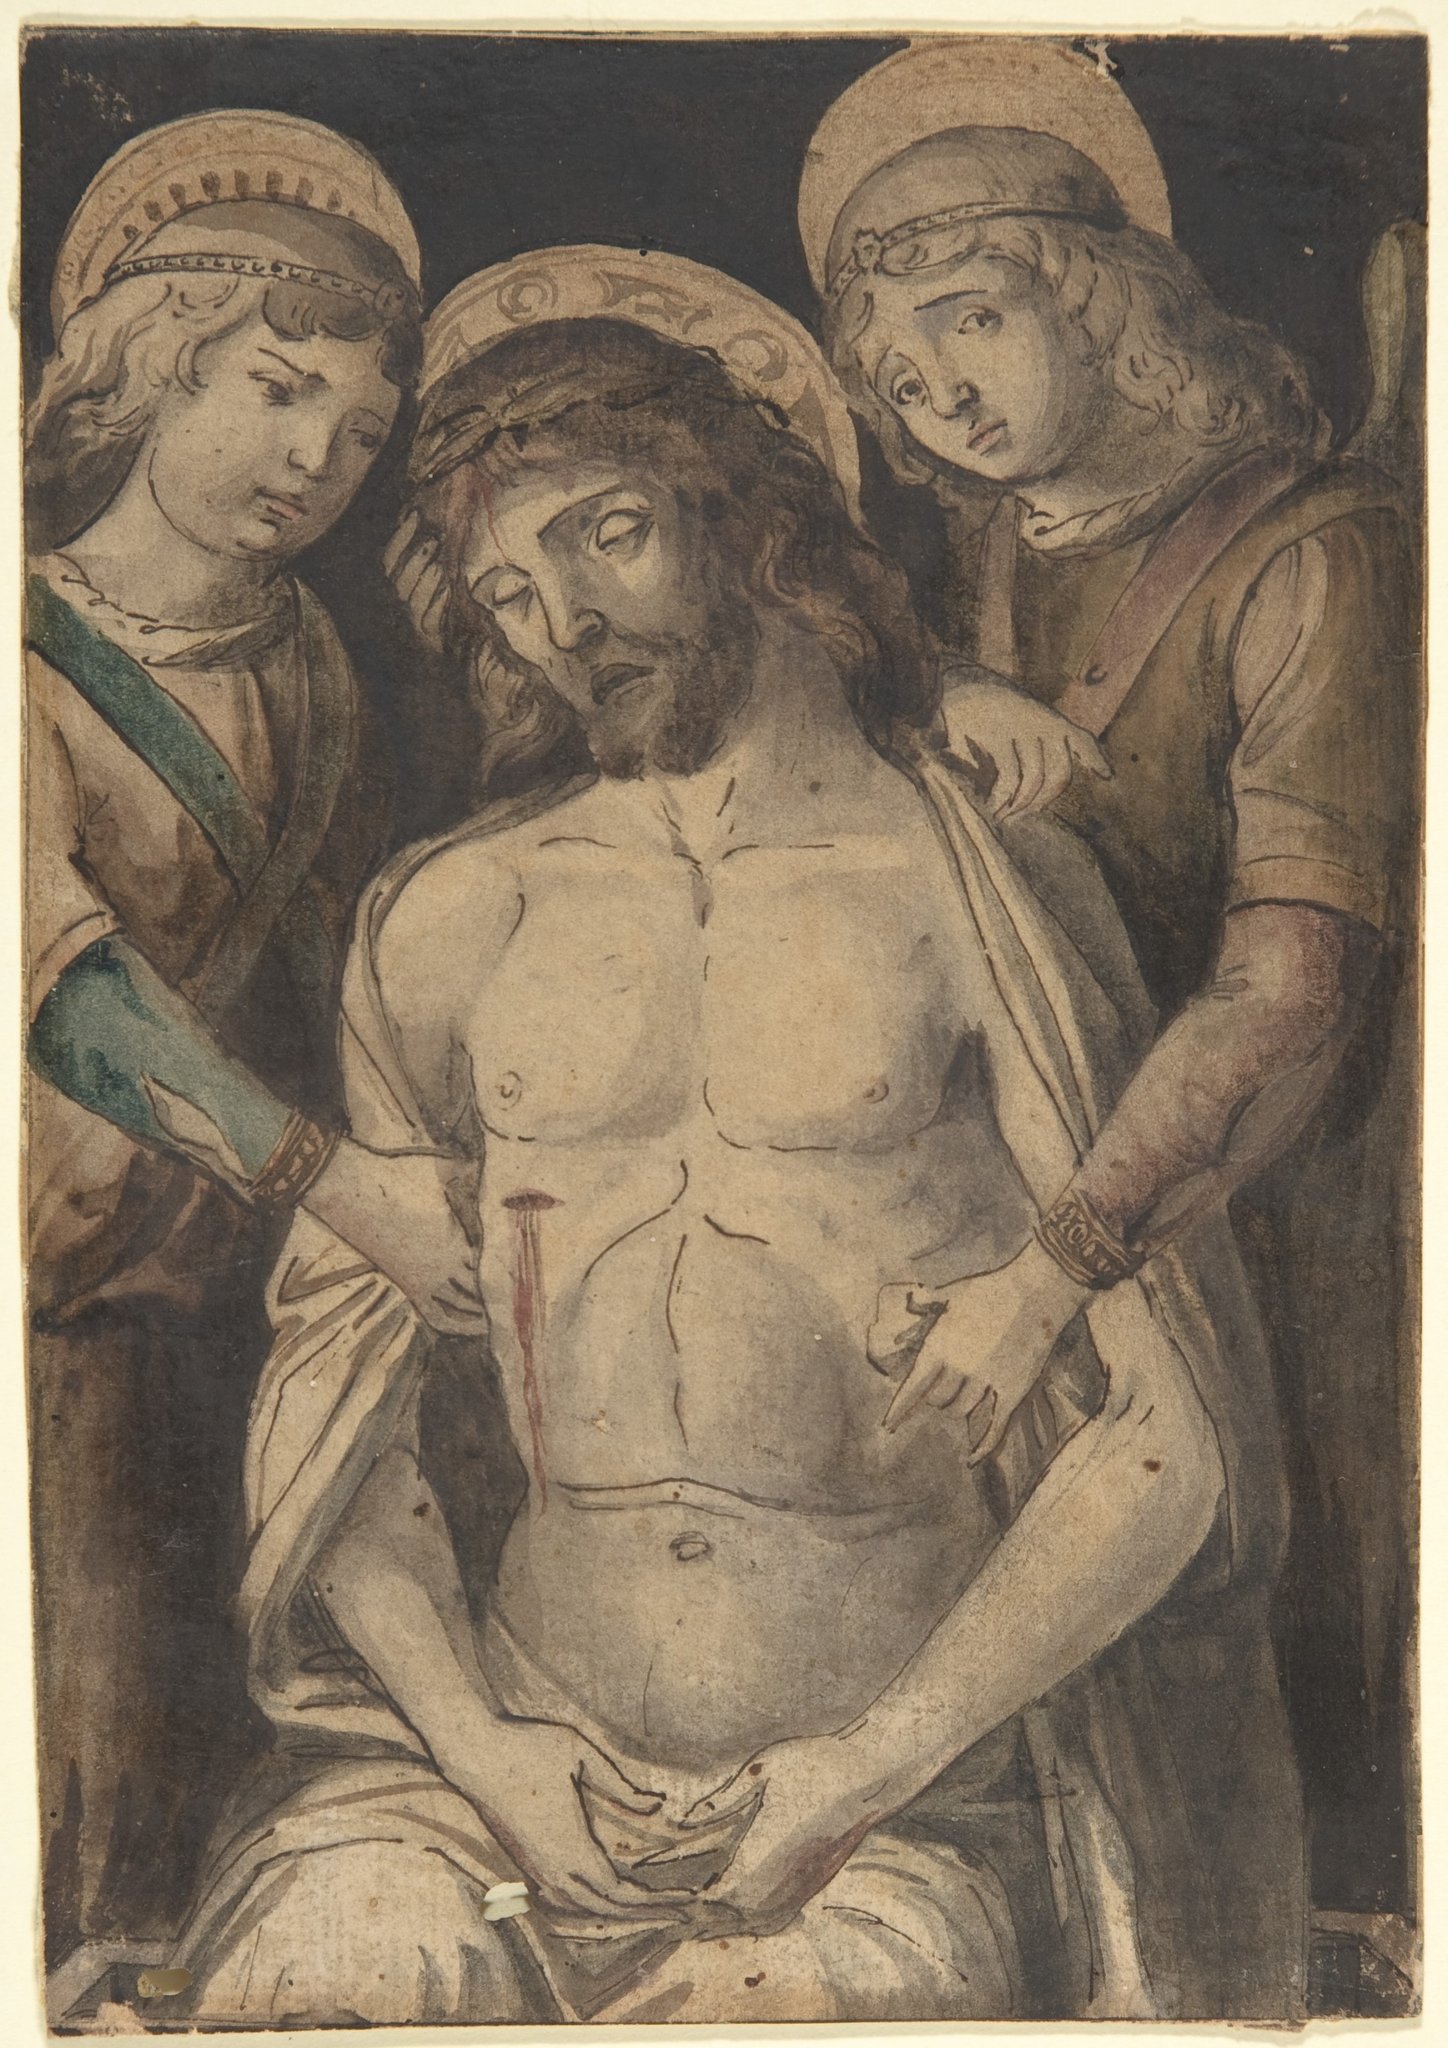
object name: drawing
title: Pietà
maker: anonymous, italian, 19th century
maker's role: artist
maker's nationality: italian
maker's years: 1800-1900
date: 1800-1900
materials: ink, watercolor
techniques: pen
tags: christ,virgin mary